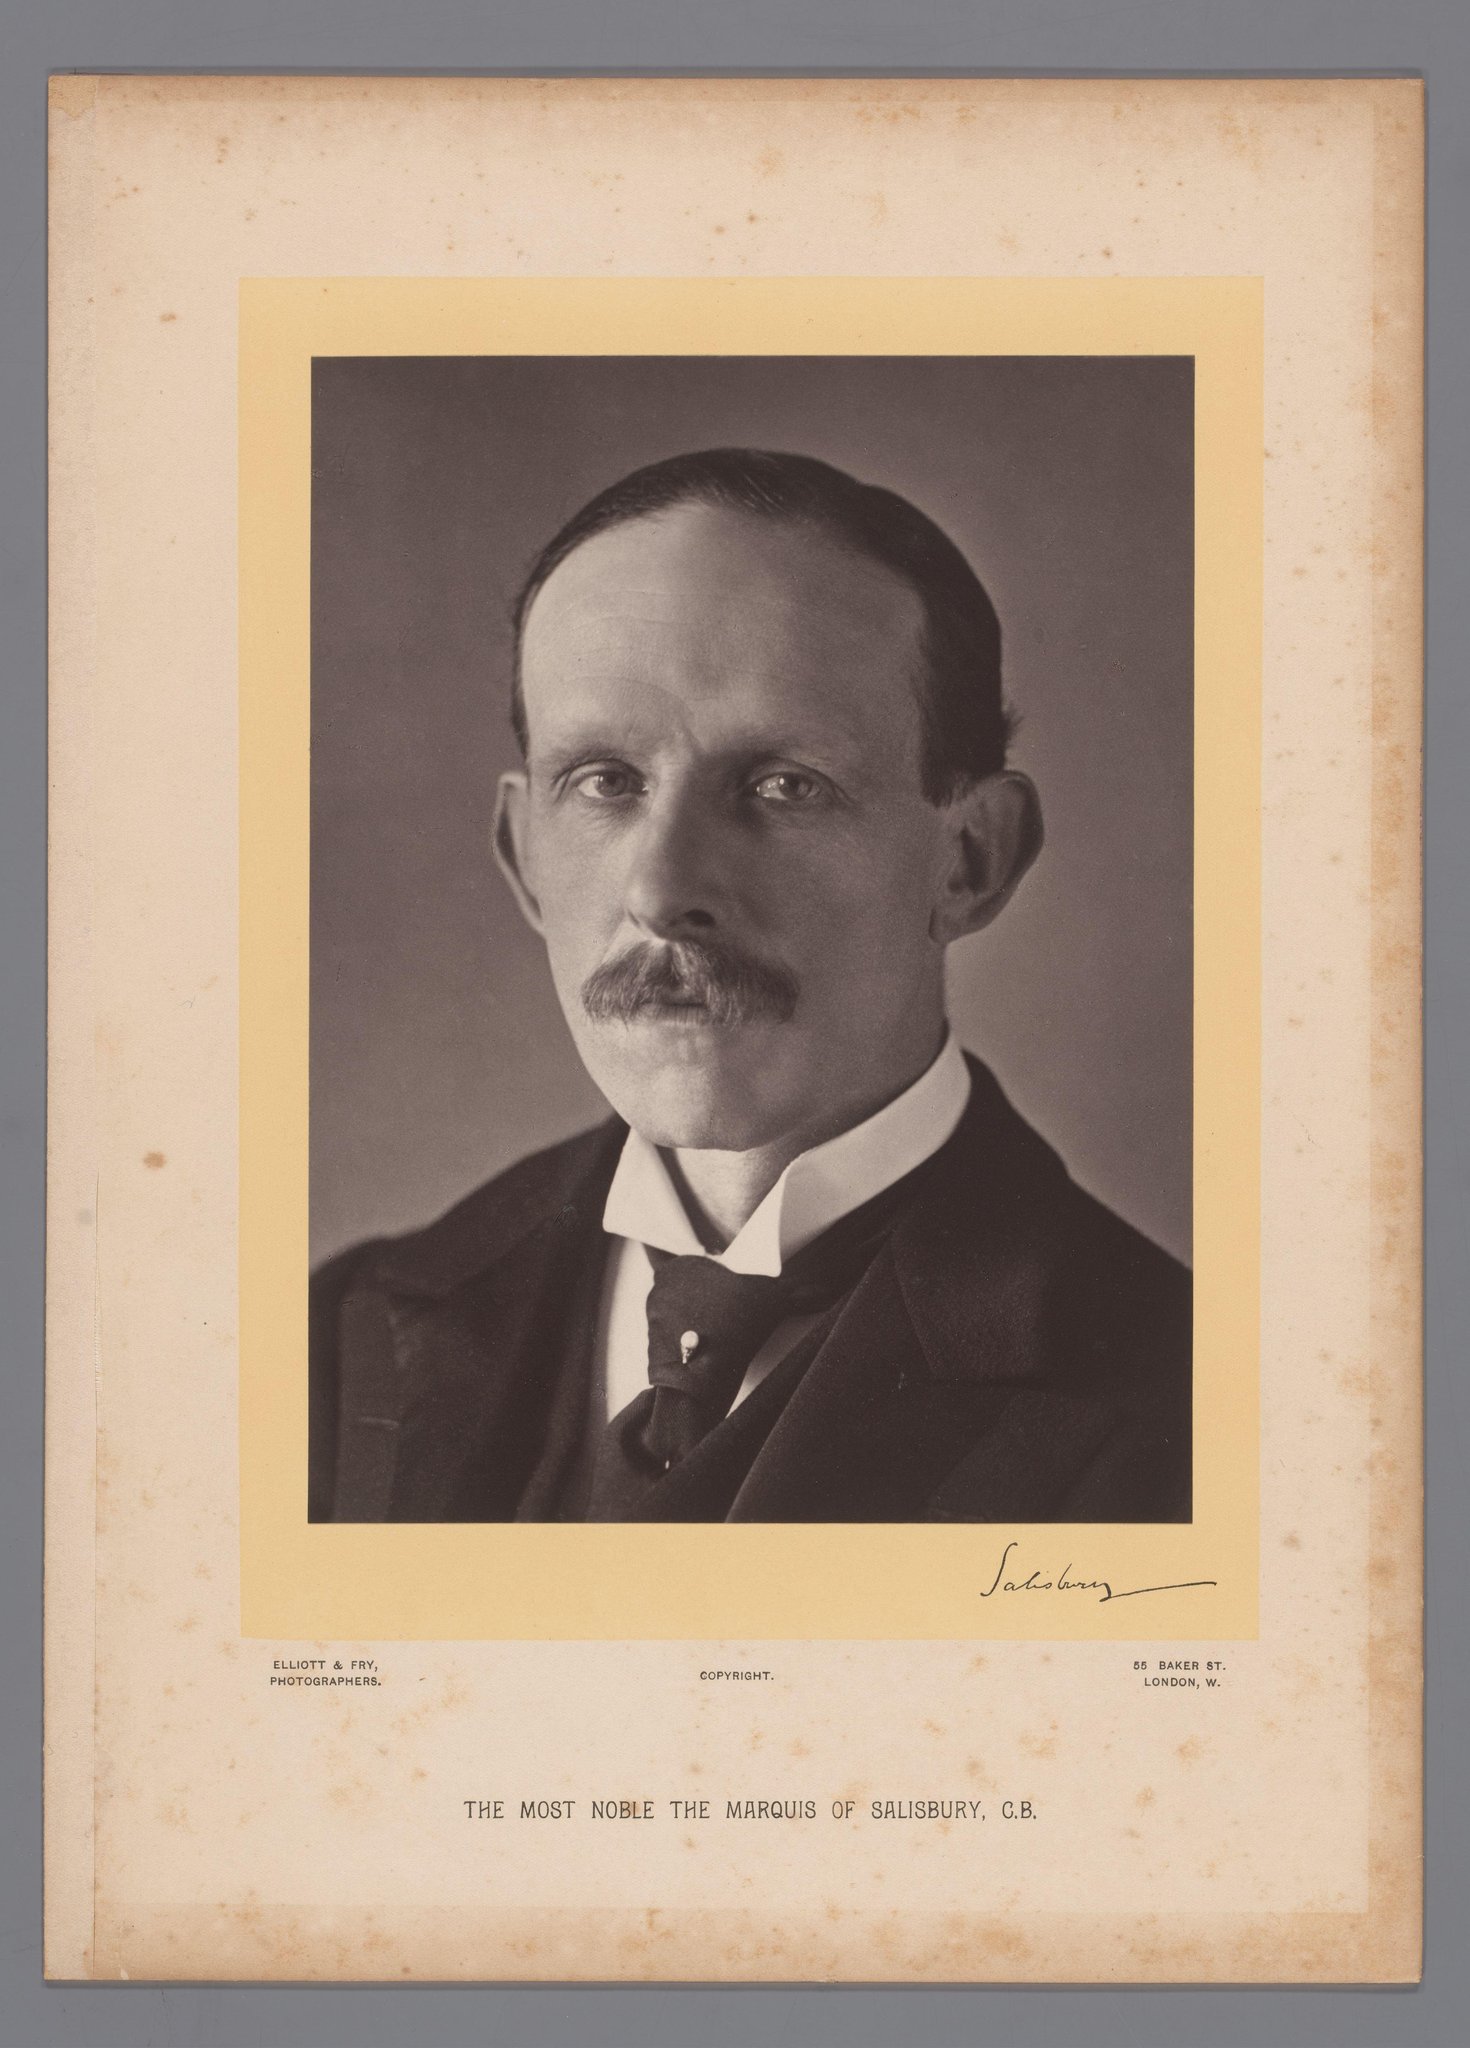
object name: photograph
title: Marquis of Salisbury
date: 1890-1910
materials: cardboard, paper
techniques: carbon print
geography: london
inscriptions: caption: ‘Elliott & Fry//photographers//Copyright.//55., Baker St.,//London W.’, caption: ‘The Most Noble The Marquis of Salisbury, C.B.’, caption: ‘Salisbury’